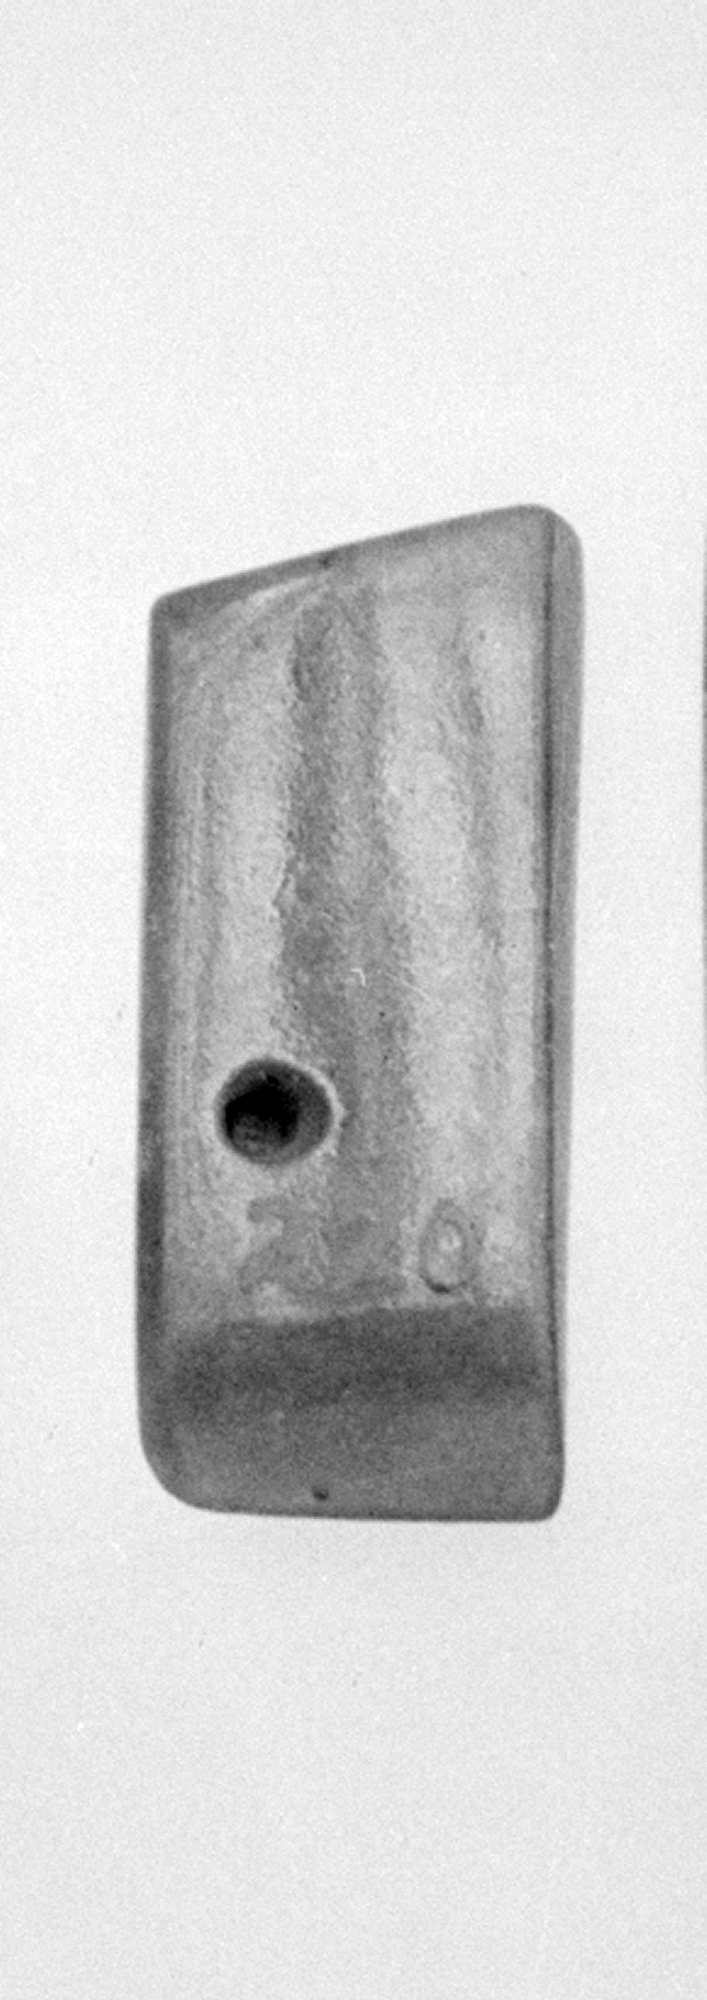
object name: chisel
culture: mexican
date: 1902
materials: jade